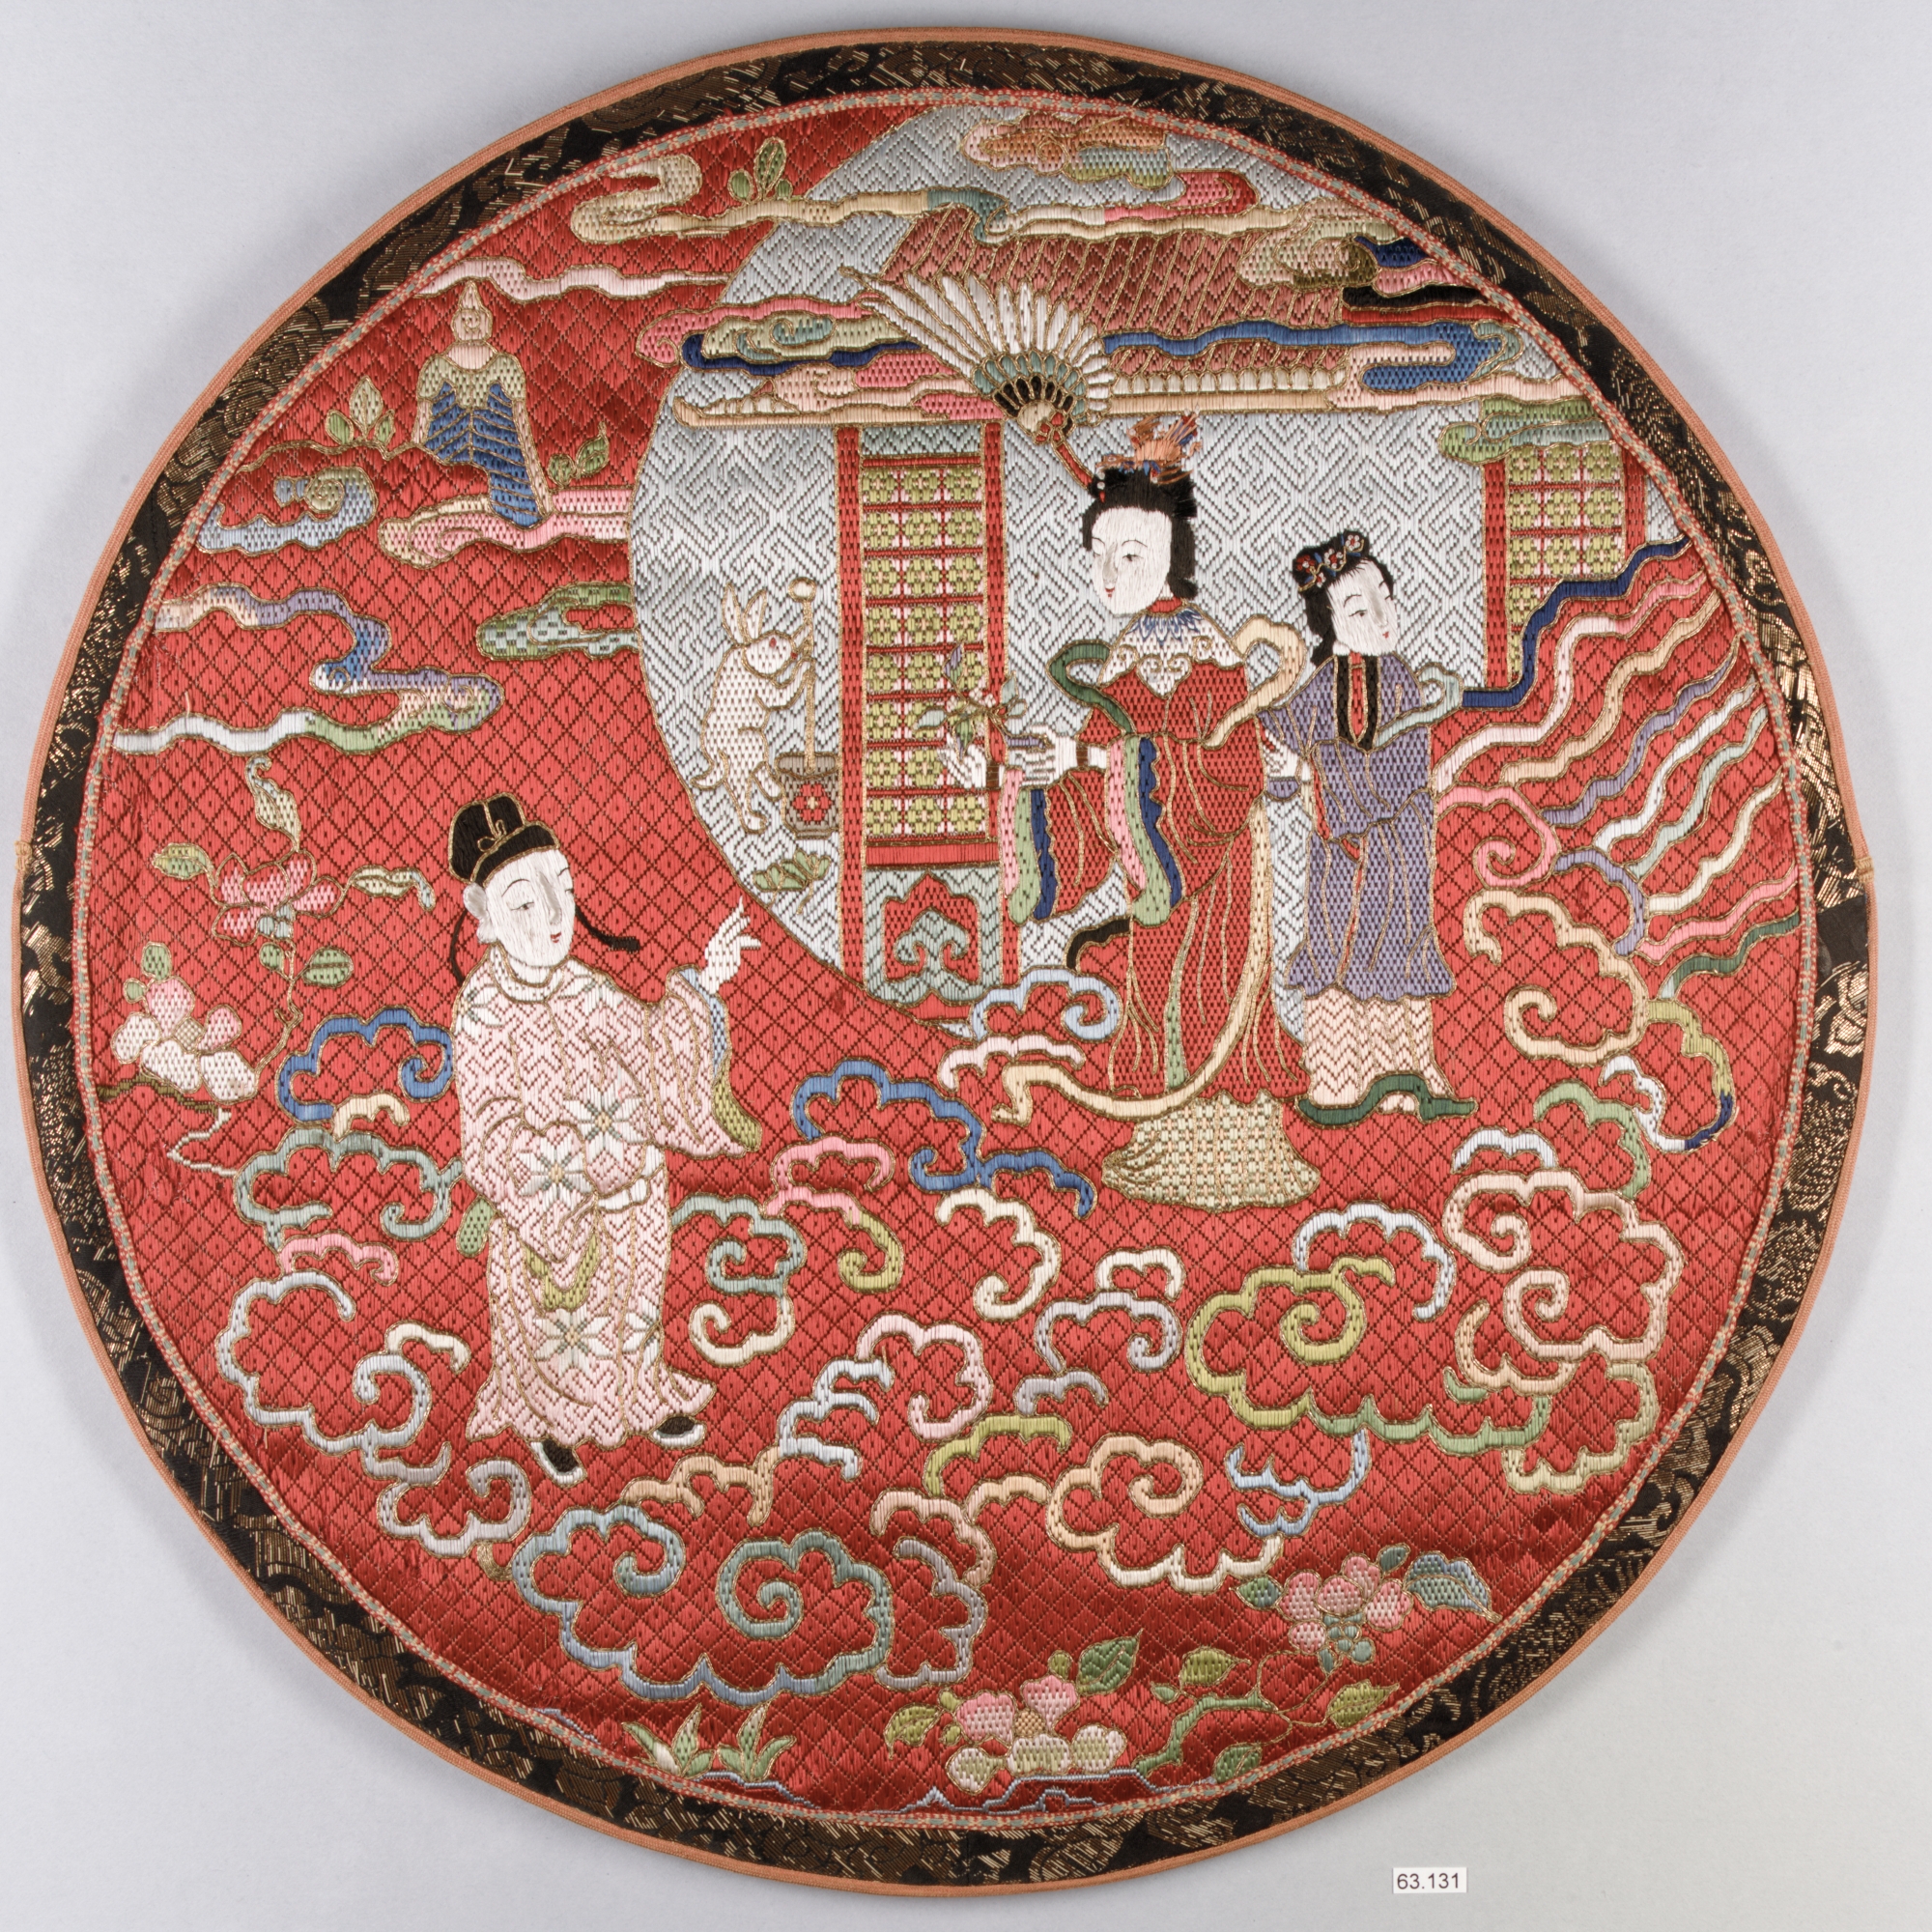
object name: mirror case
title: Mirror case with lunar scene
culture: chinese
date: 1801-1900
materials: textile, silk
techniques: embroidery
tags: fans,women,rabbits,flowers